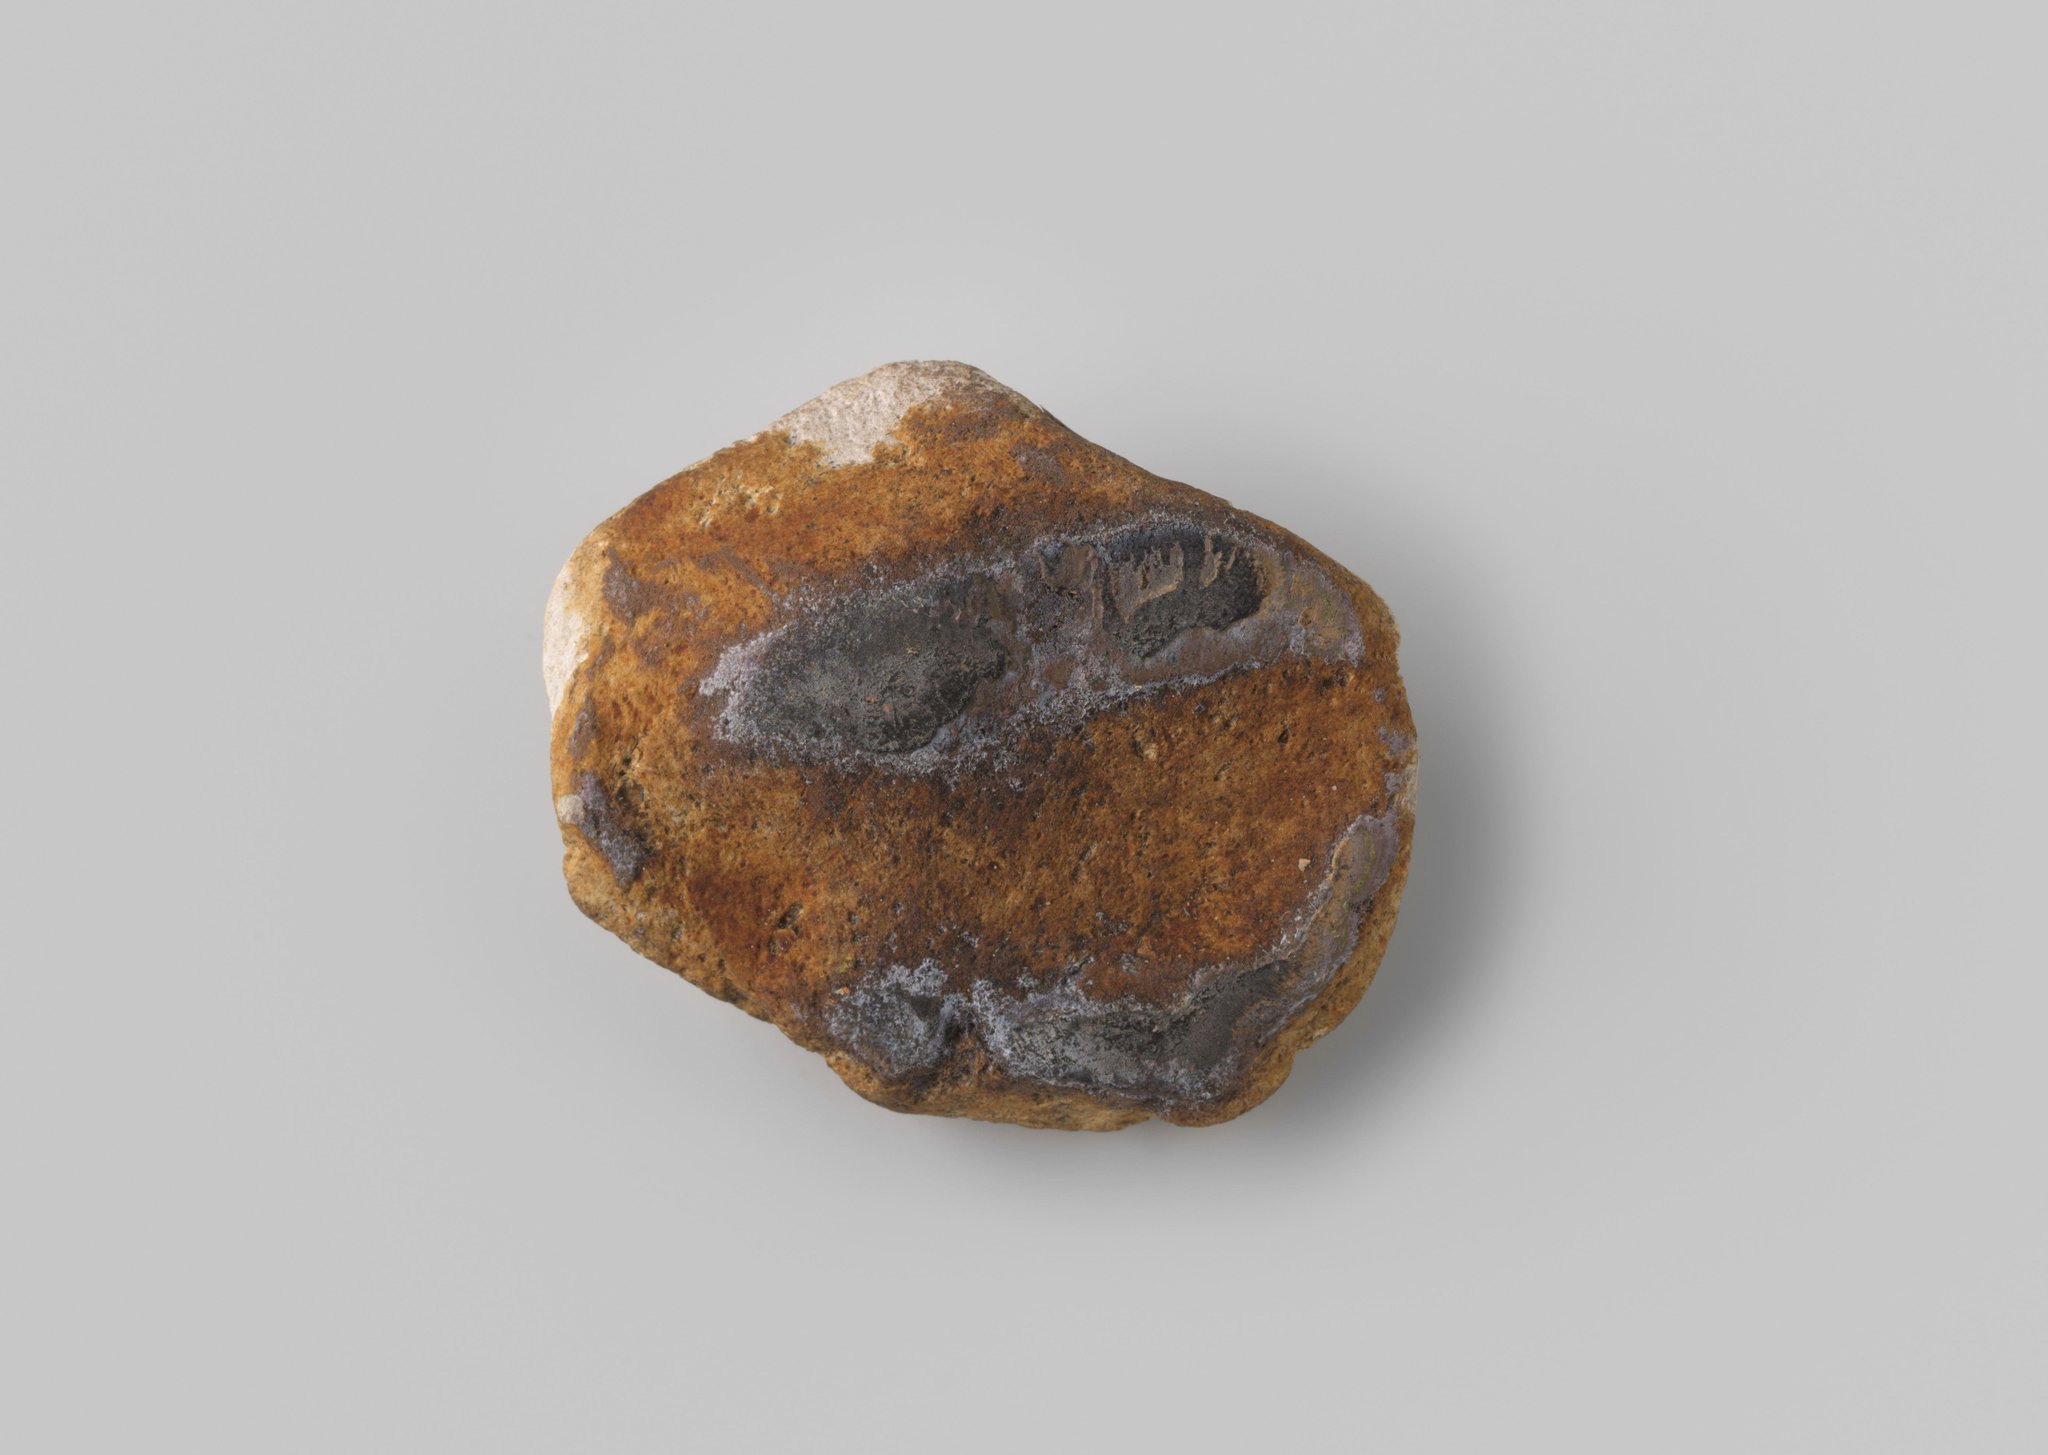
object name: sherd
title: Brok grijs materiaal met bruine onderzijde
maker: Anonymous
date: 1200-1899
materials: earthenware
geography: italy